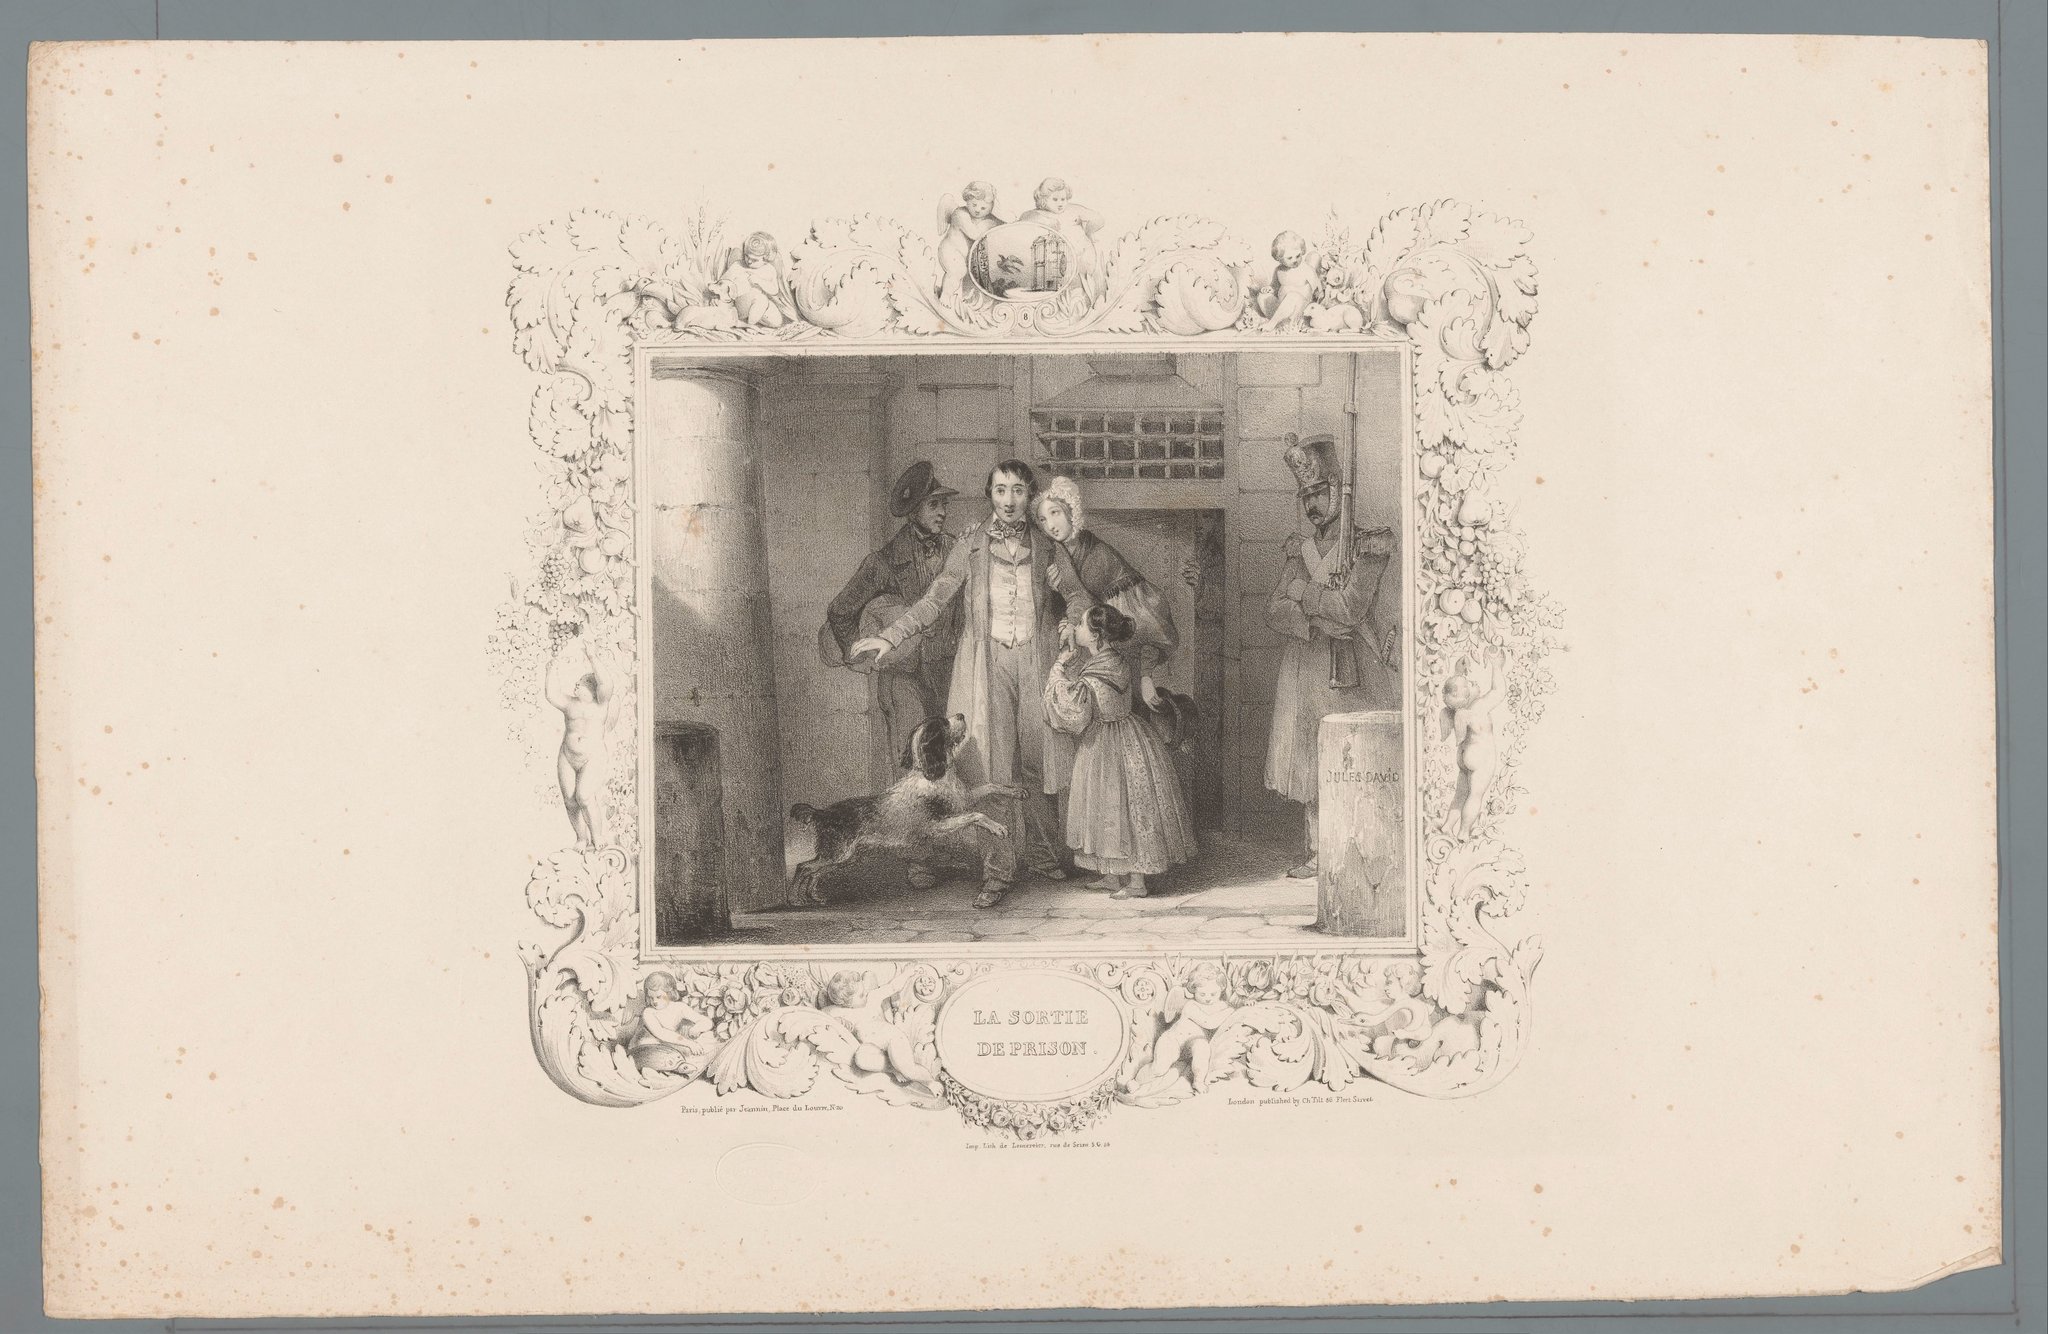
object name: print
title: La sortie de prison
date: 1836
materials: paper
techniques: lithograph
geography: paris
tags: prison, jail, release from prison, empty bird cage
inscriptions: check stamp: Lugt 1397c, collector's mark: Lugt 2228a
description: Prent uit: La Revue des Peintres. Parijs: Aubert et Cie, 1836.